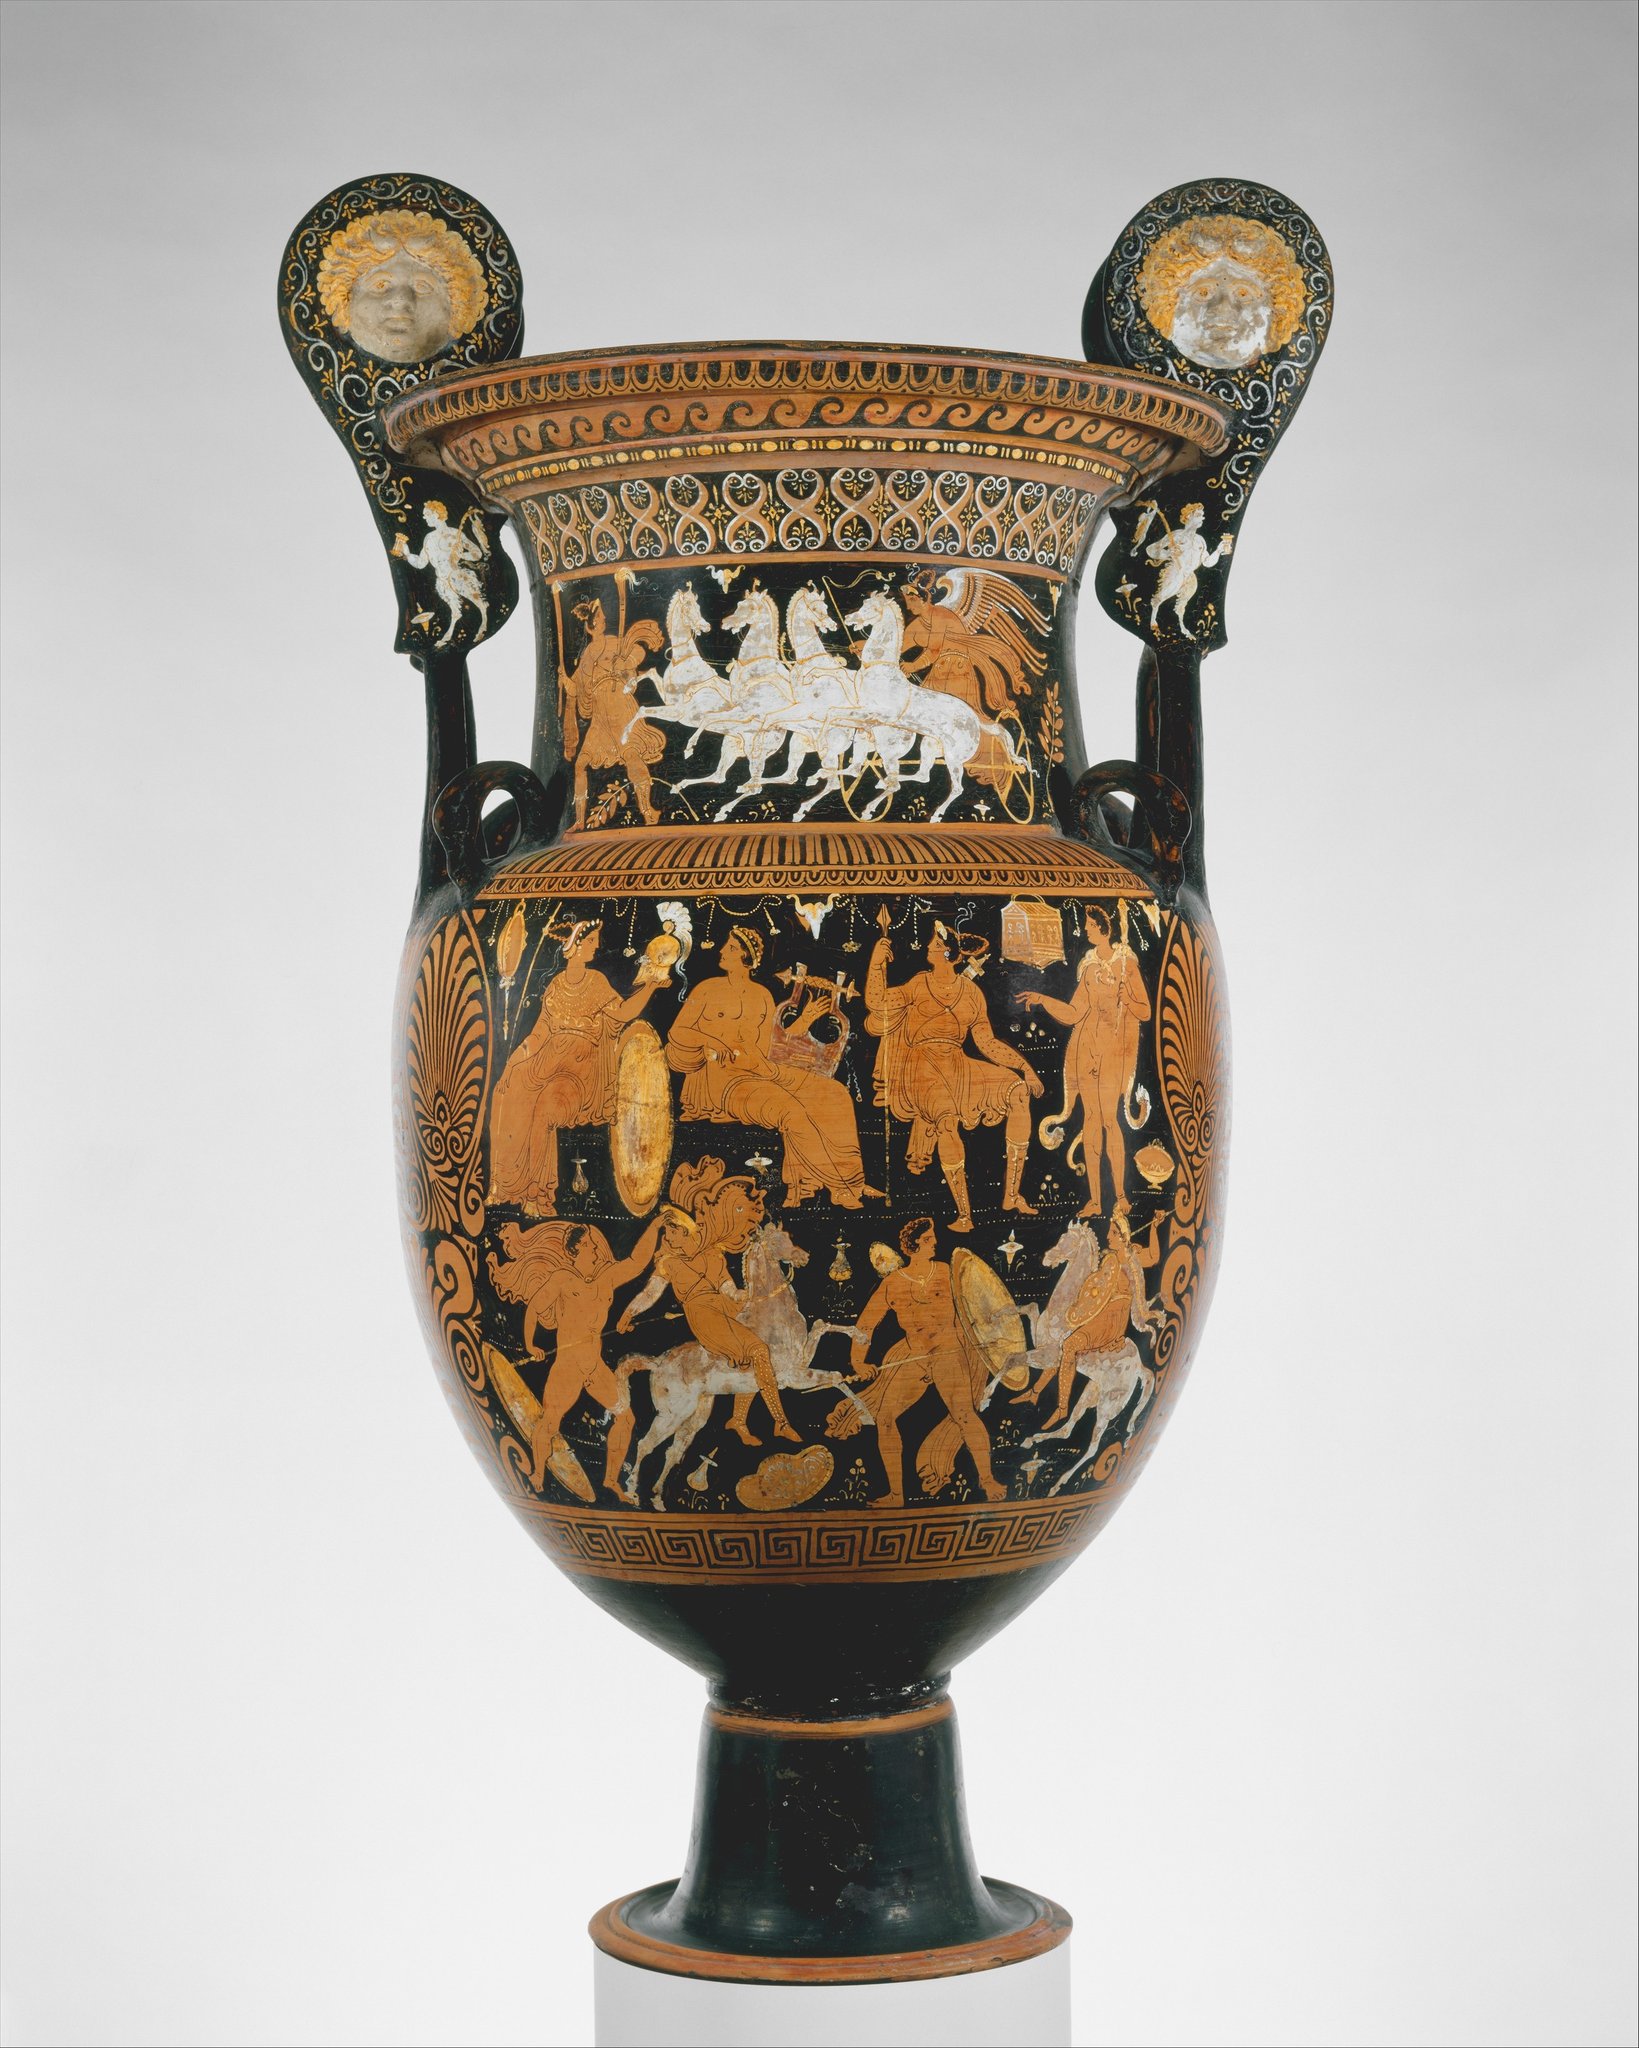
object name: volute krater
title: Terracotta volute-krater (vase for mixing wine and water)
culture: greek, south italian, apulian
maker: capodimonte painter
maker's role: artist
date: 320-310 BCE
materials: terracotta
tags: musical instruments,men,male nudes,women,nike,horses,chariots